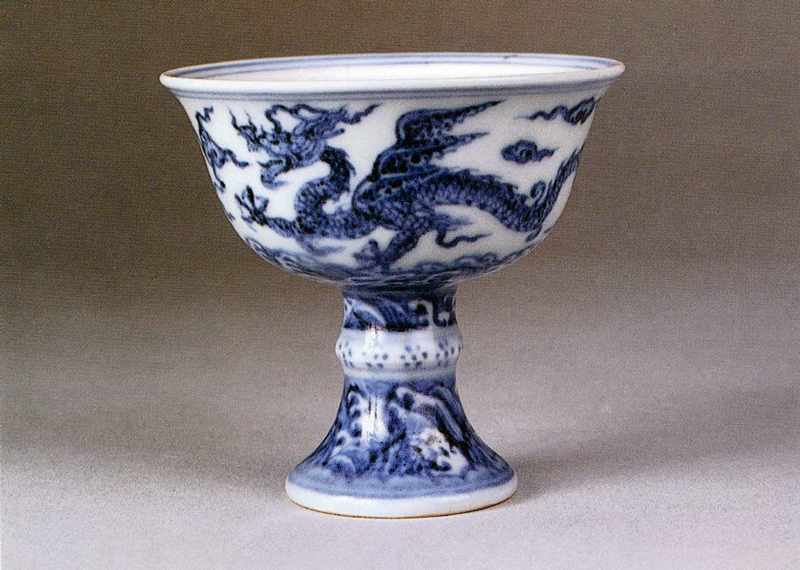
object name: stem cup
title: Small stem cup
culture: chinese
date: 1426-1435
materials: cobalt, glaze, porcelain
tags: dragons